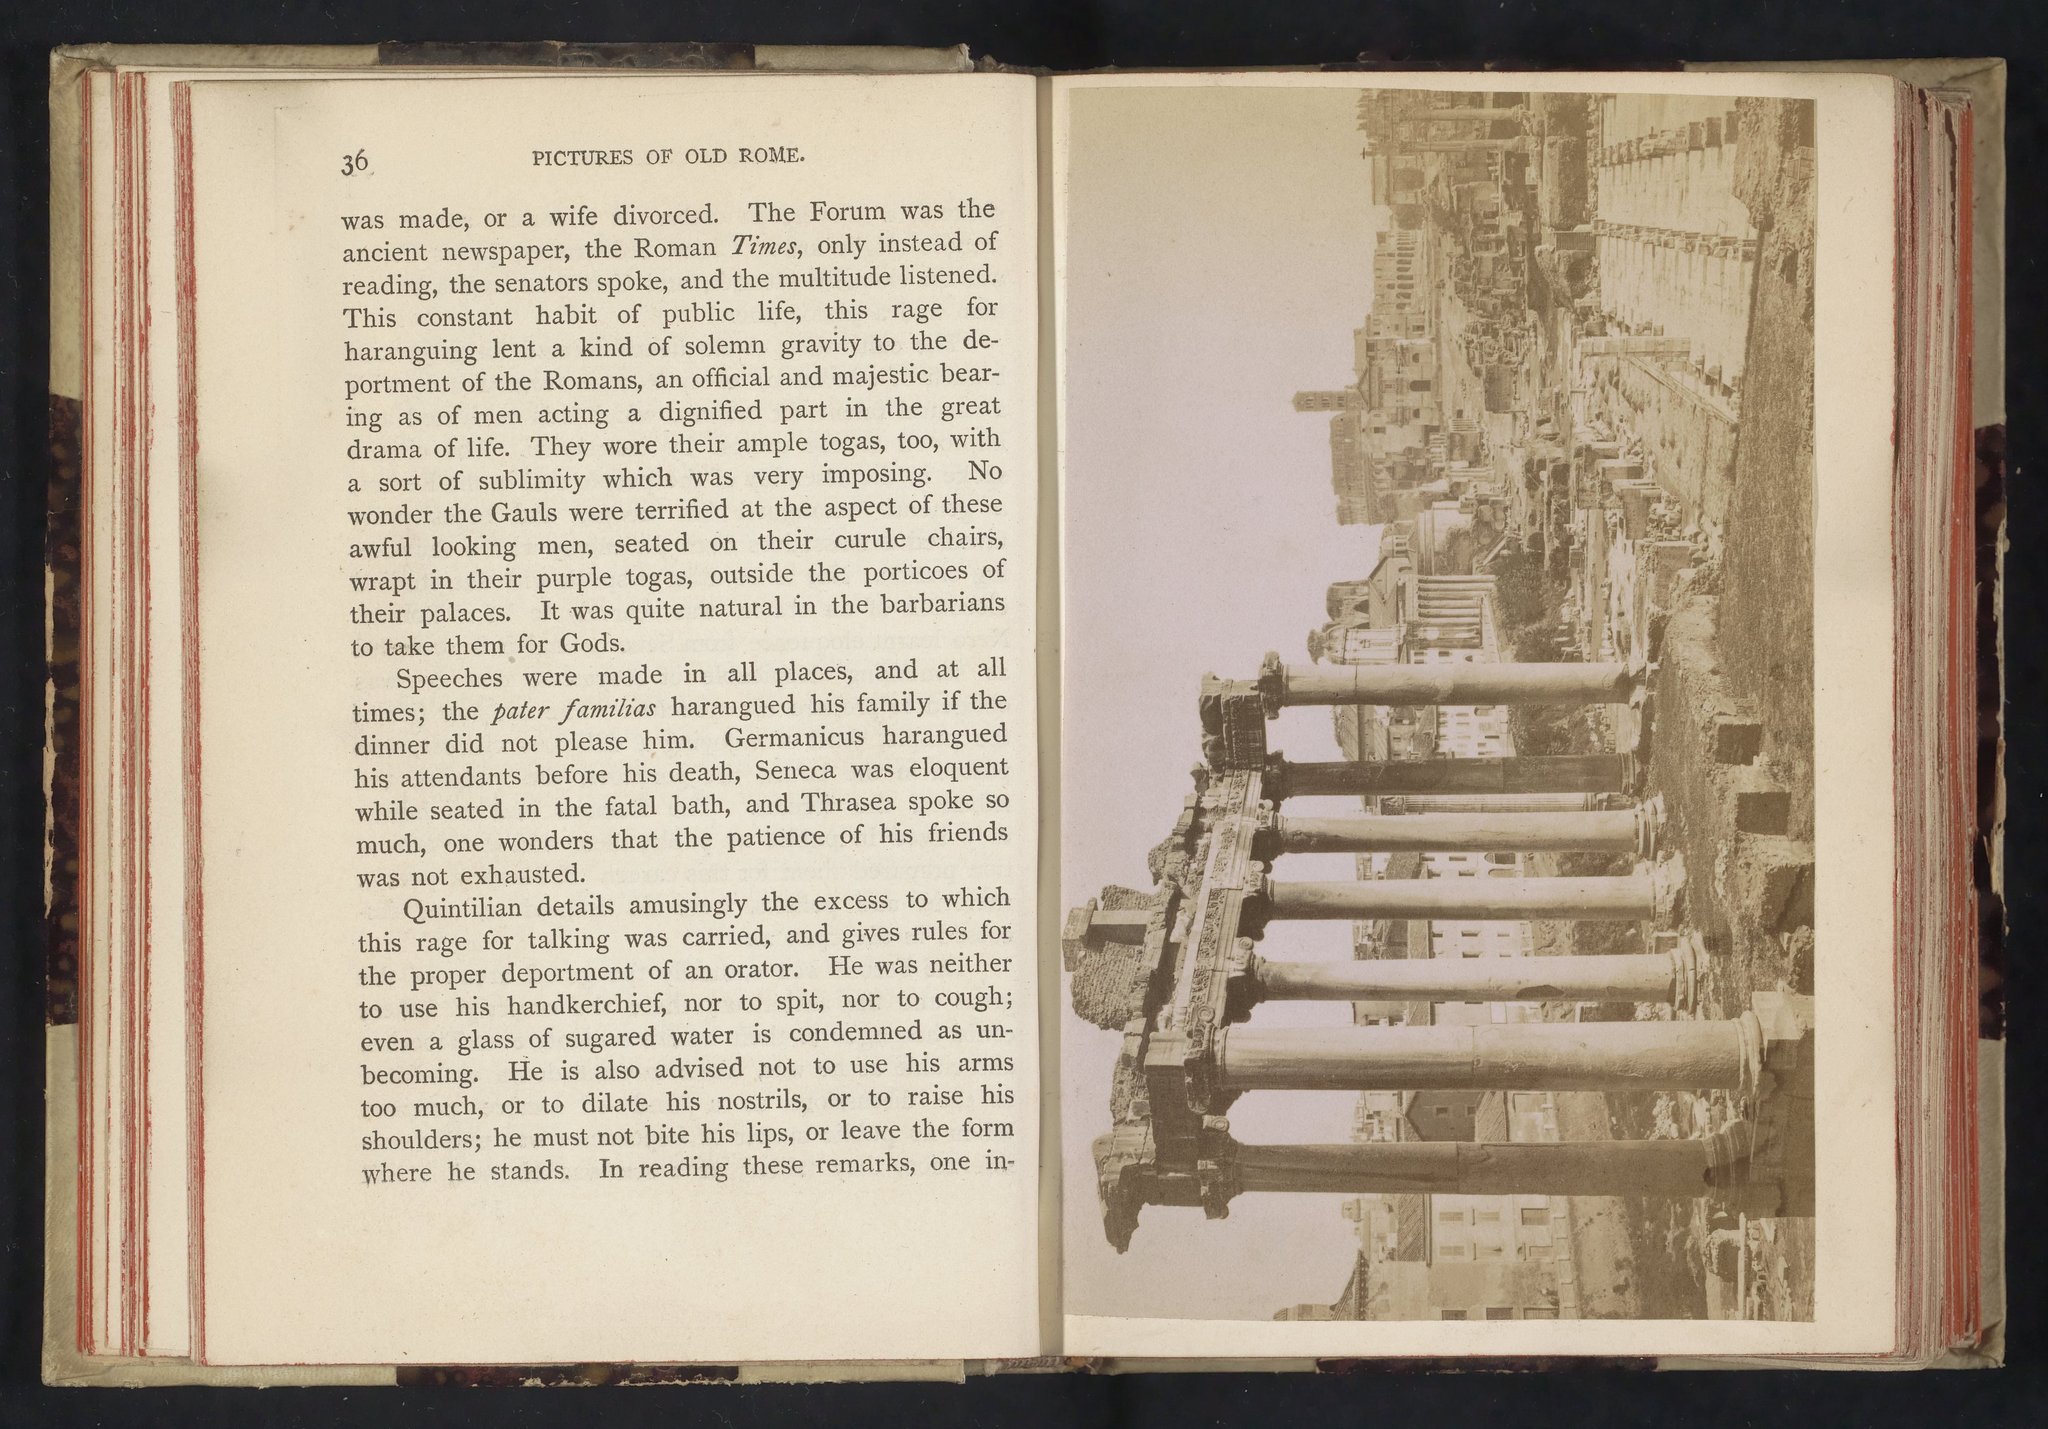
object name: photograph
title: Gezicht op het Forum Romanum, met op de voorgrond de ruïne van de Tempel van Saturnus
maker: Anonymous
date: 1872-1882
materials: photographic support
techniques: albumen print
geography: forum romanum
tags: rome, landscape with ruins, temple, shrine ~ roman religion